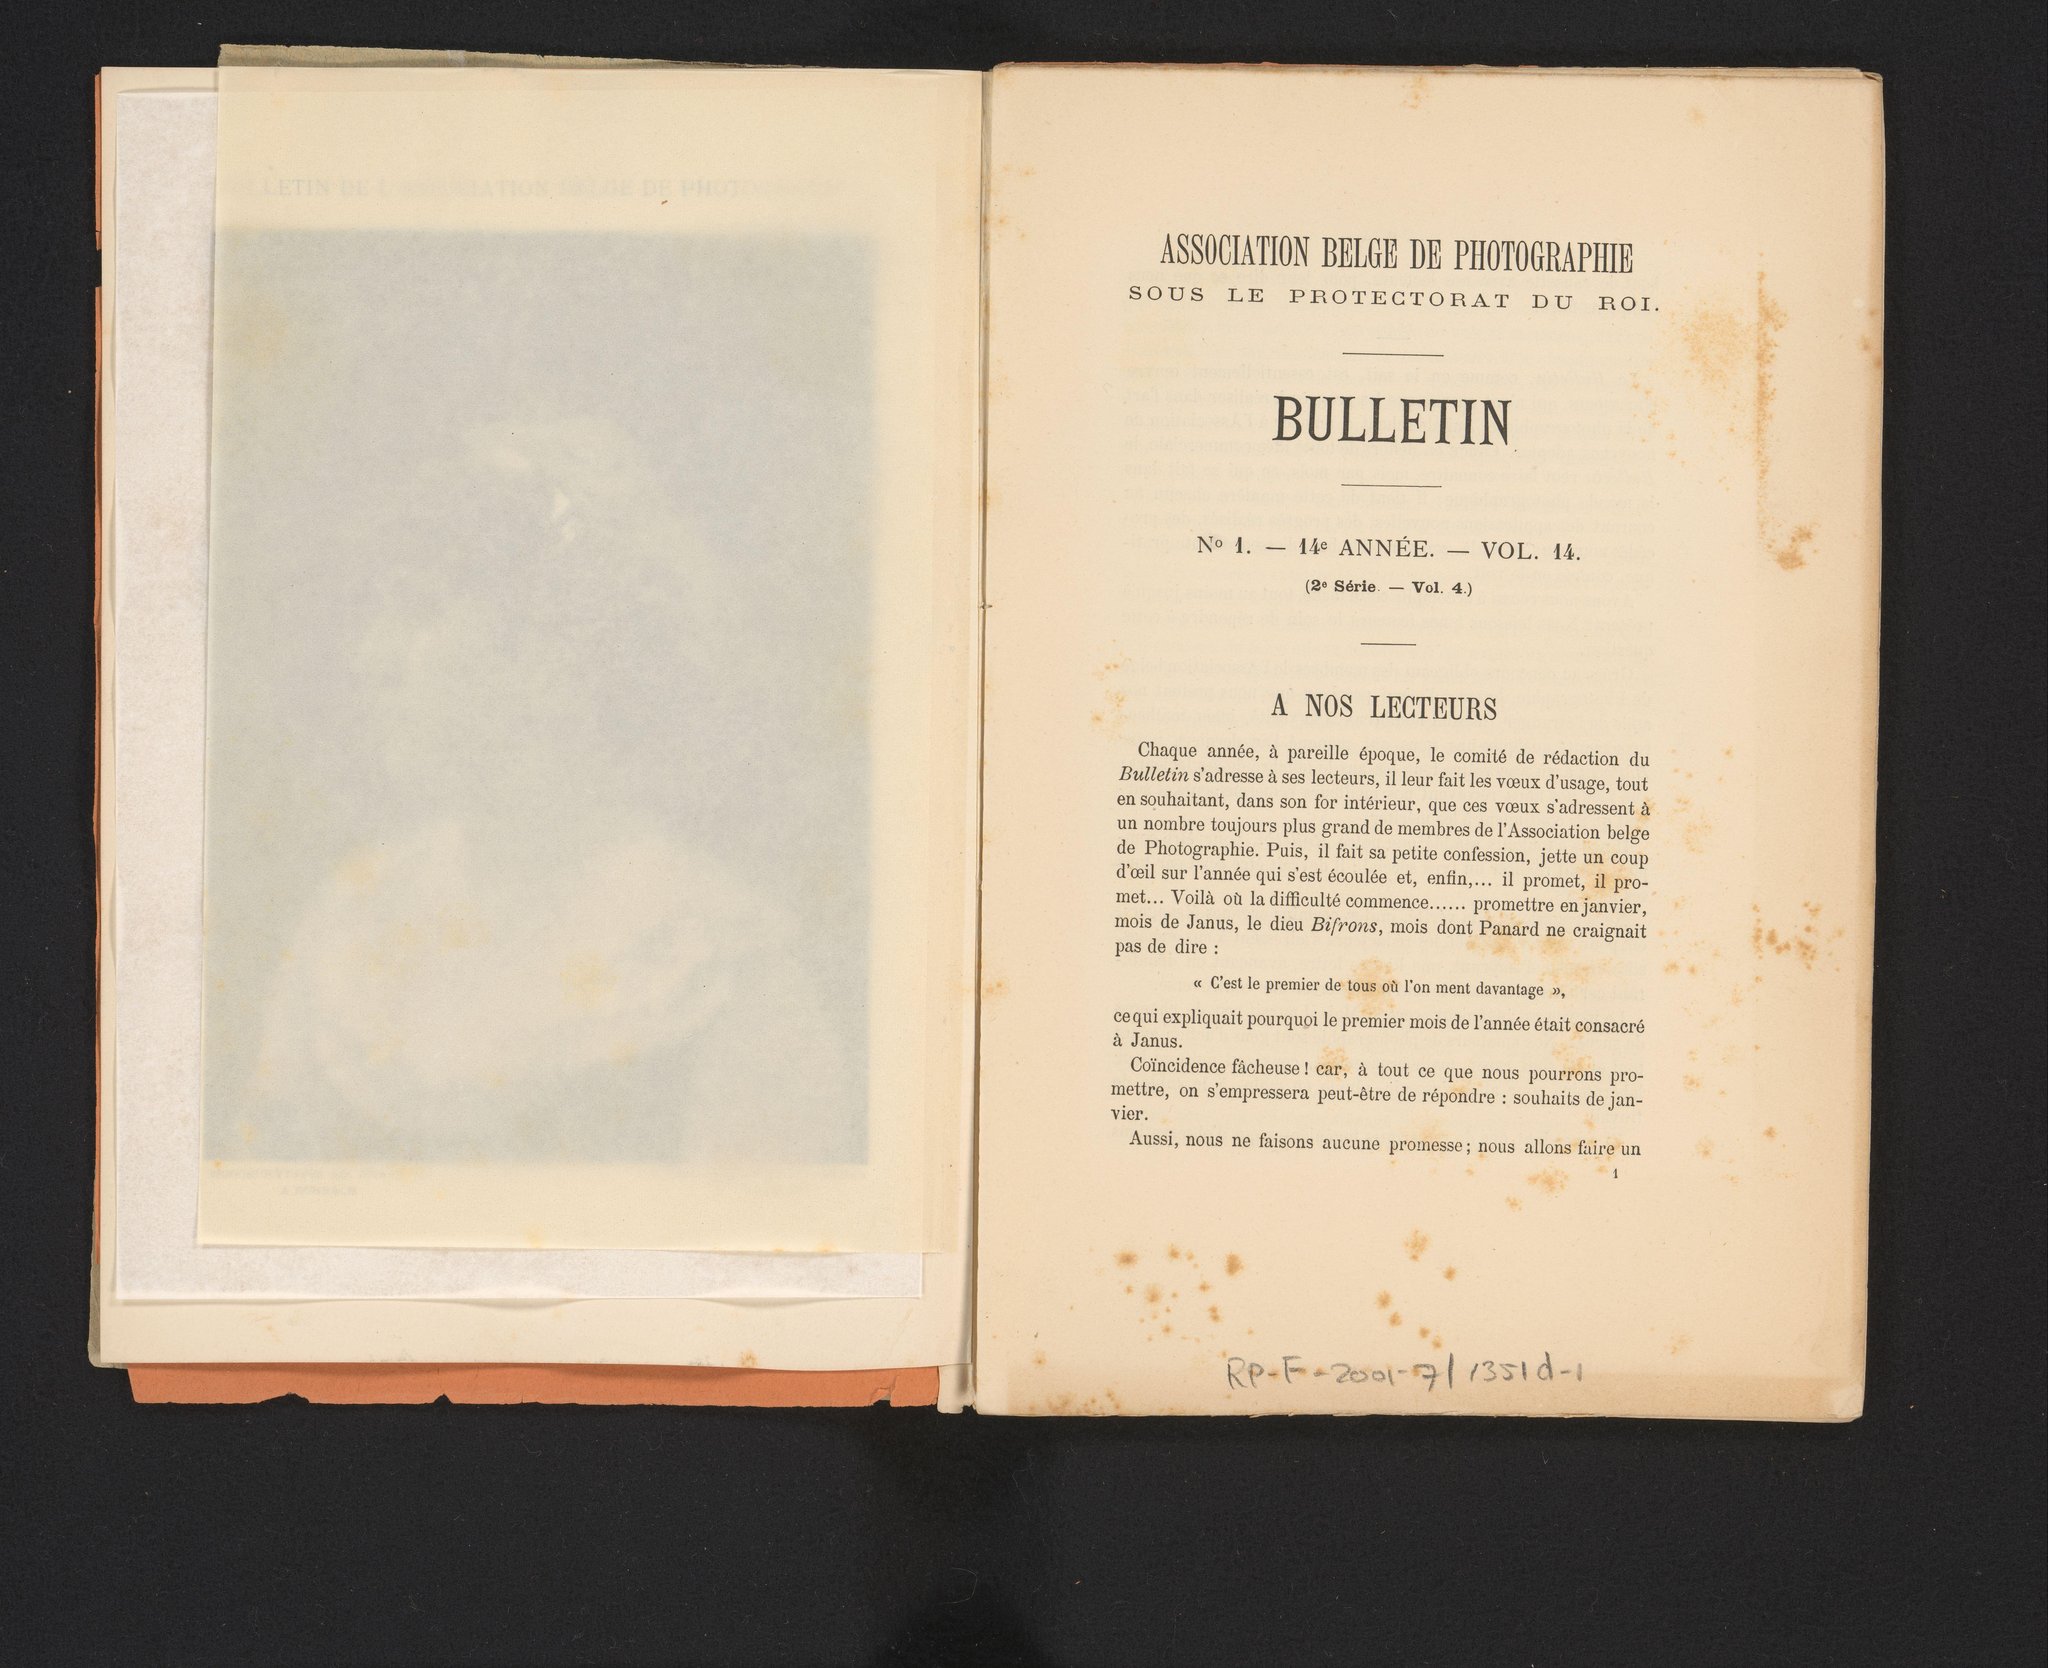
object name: book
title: Bulletin / Association belge de photographie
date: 1801-1887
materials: paper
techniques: printing, engraving, woodburytype